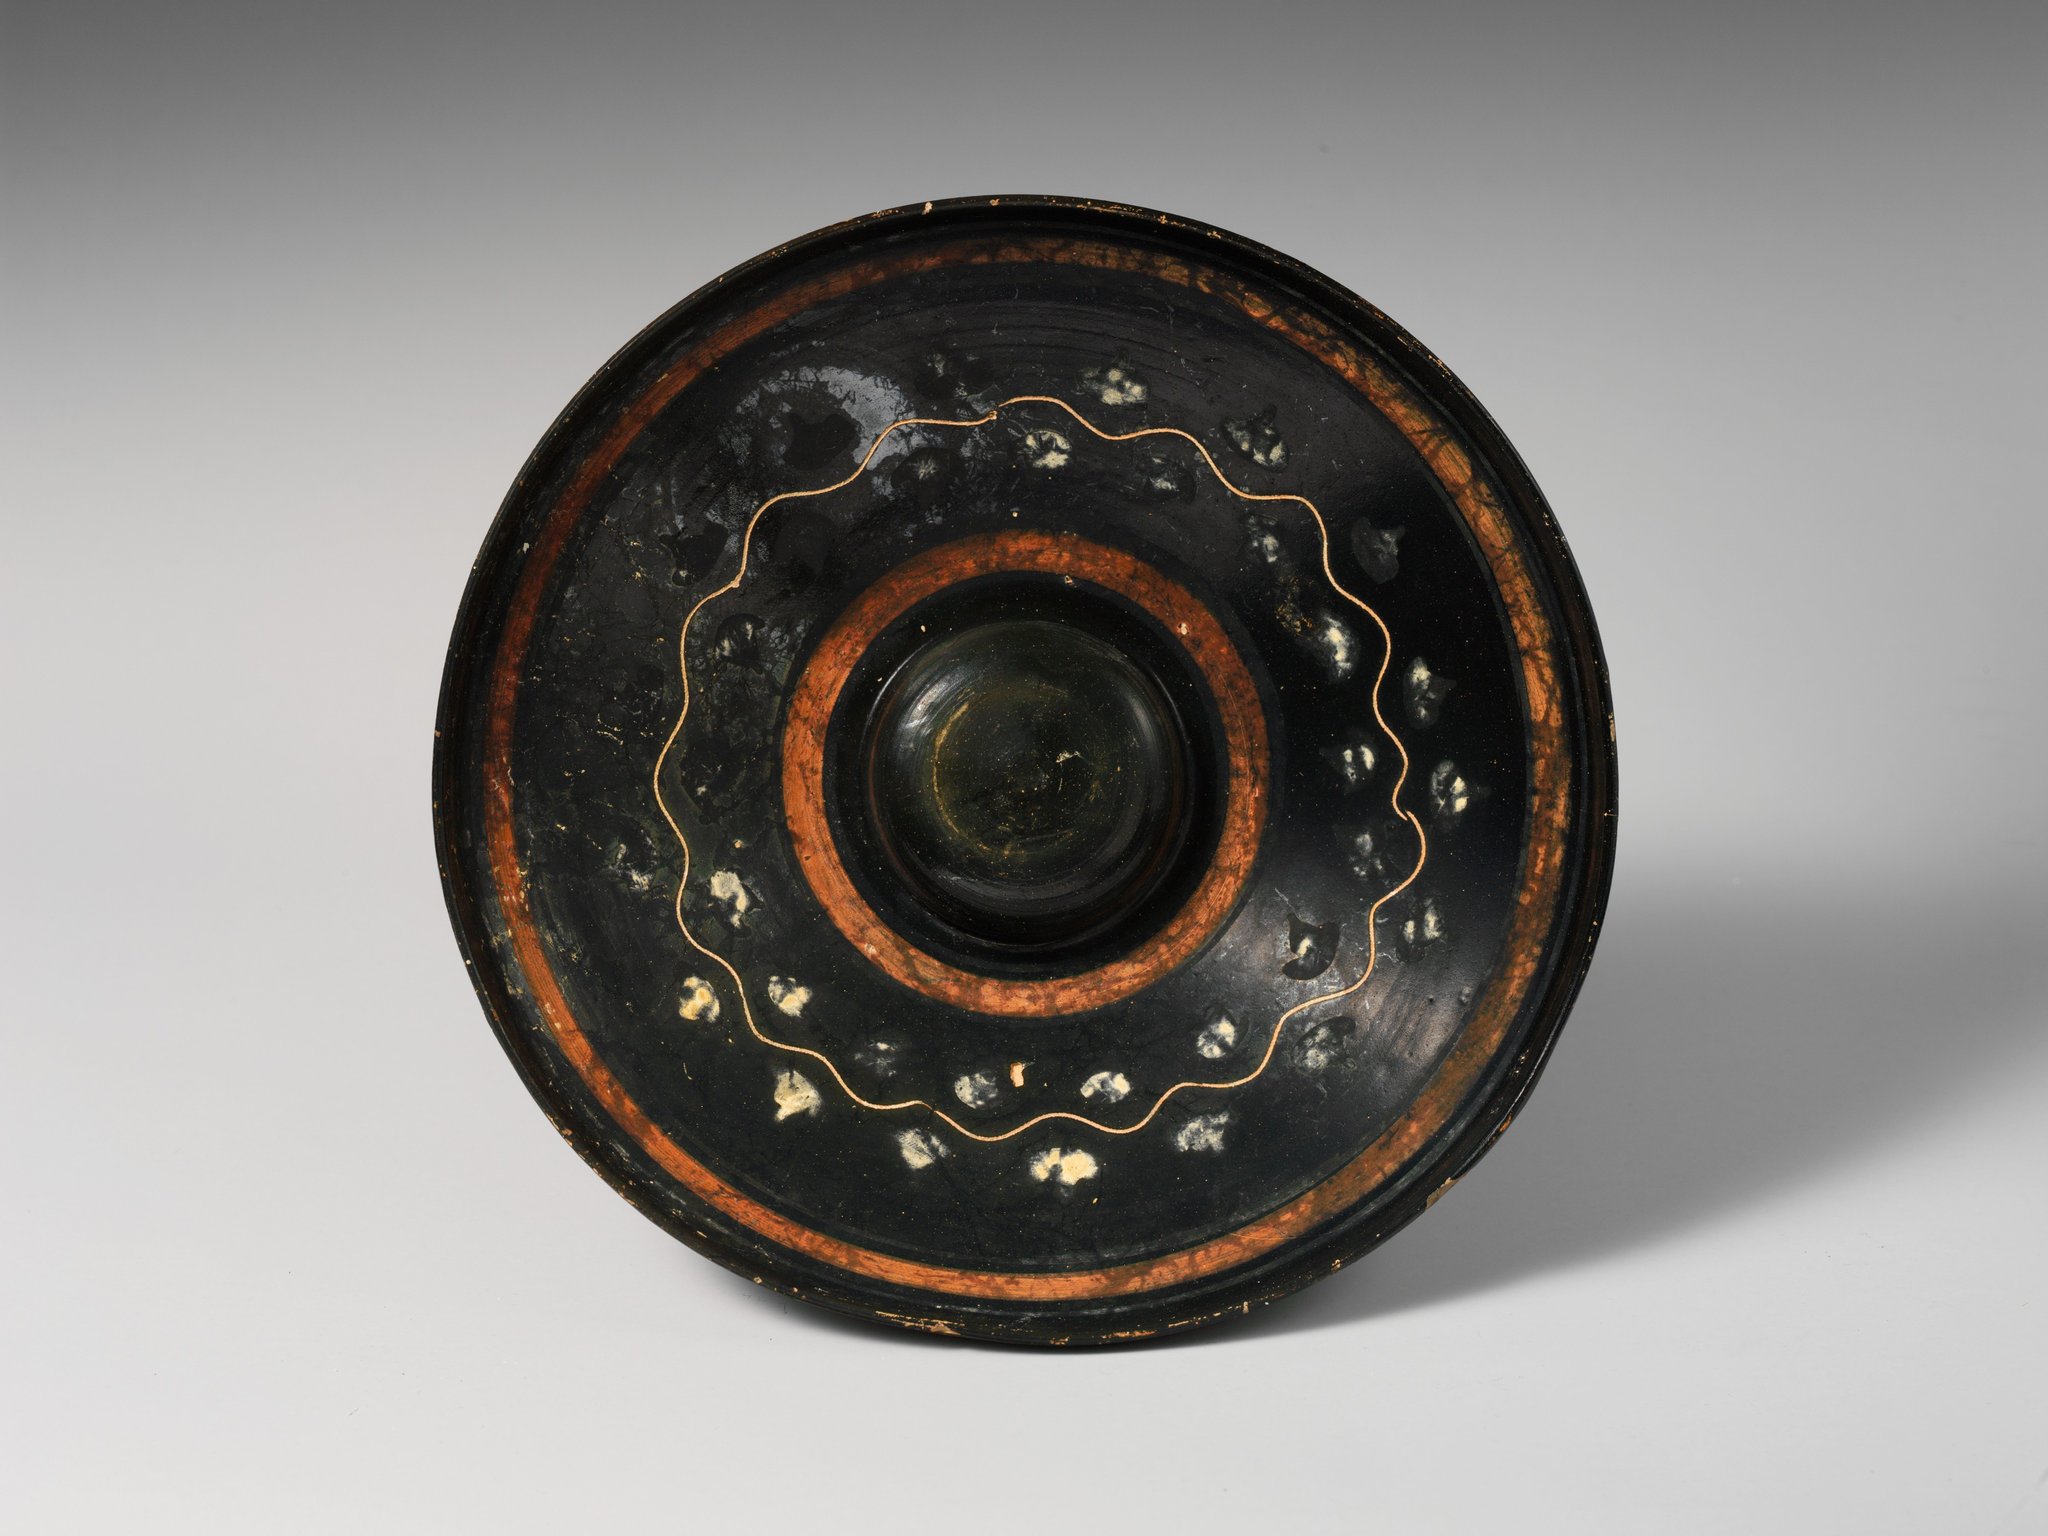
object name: phiale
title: Terracotta phiale mesomphalos (libation bowl)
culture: etruscan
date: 400-301 BCE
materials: terracotta